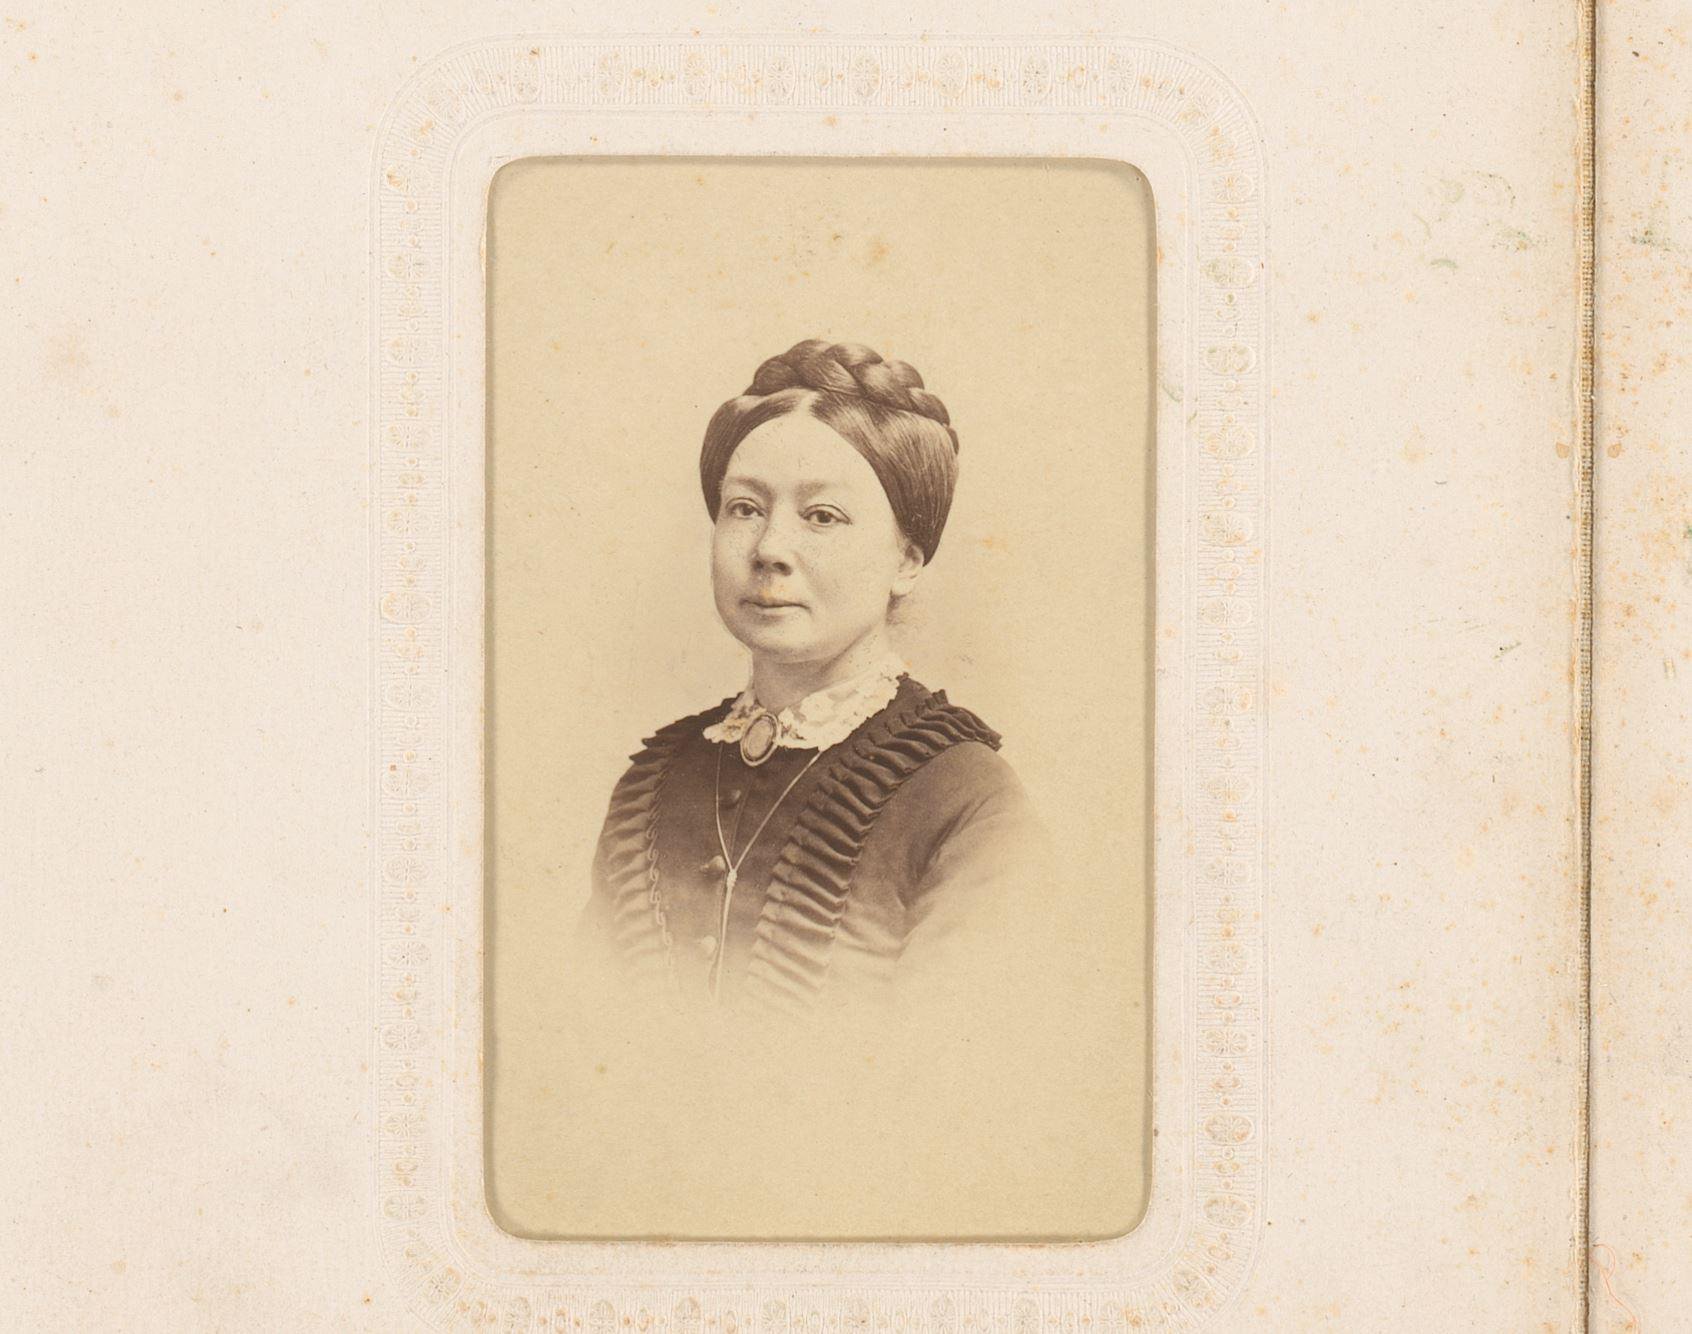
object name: photograph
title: Portret van Kee Meyer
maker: hermanus philippus jacobus schuiten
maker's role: fotograaf, lijstenmaker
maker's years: 1820-1869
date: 1850-1869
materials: cardboard, photographic support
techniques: albumen print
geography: amsterdam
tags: adolescent, young woman, maiden, historical persons - bb - woman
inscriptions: name: ‘Tante Kee Meyer’